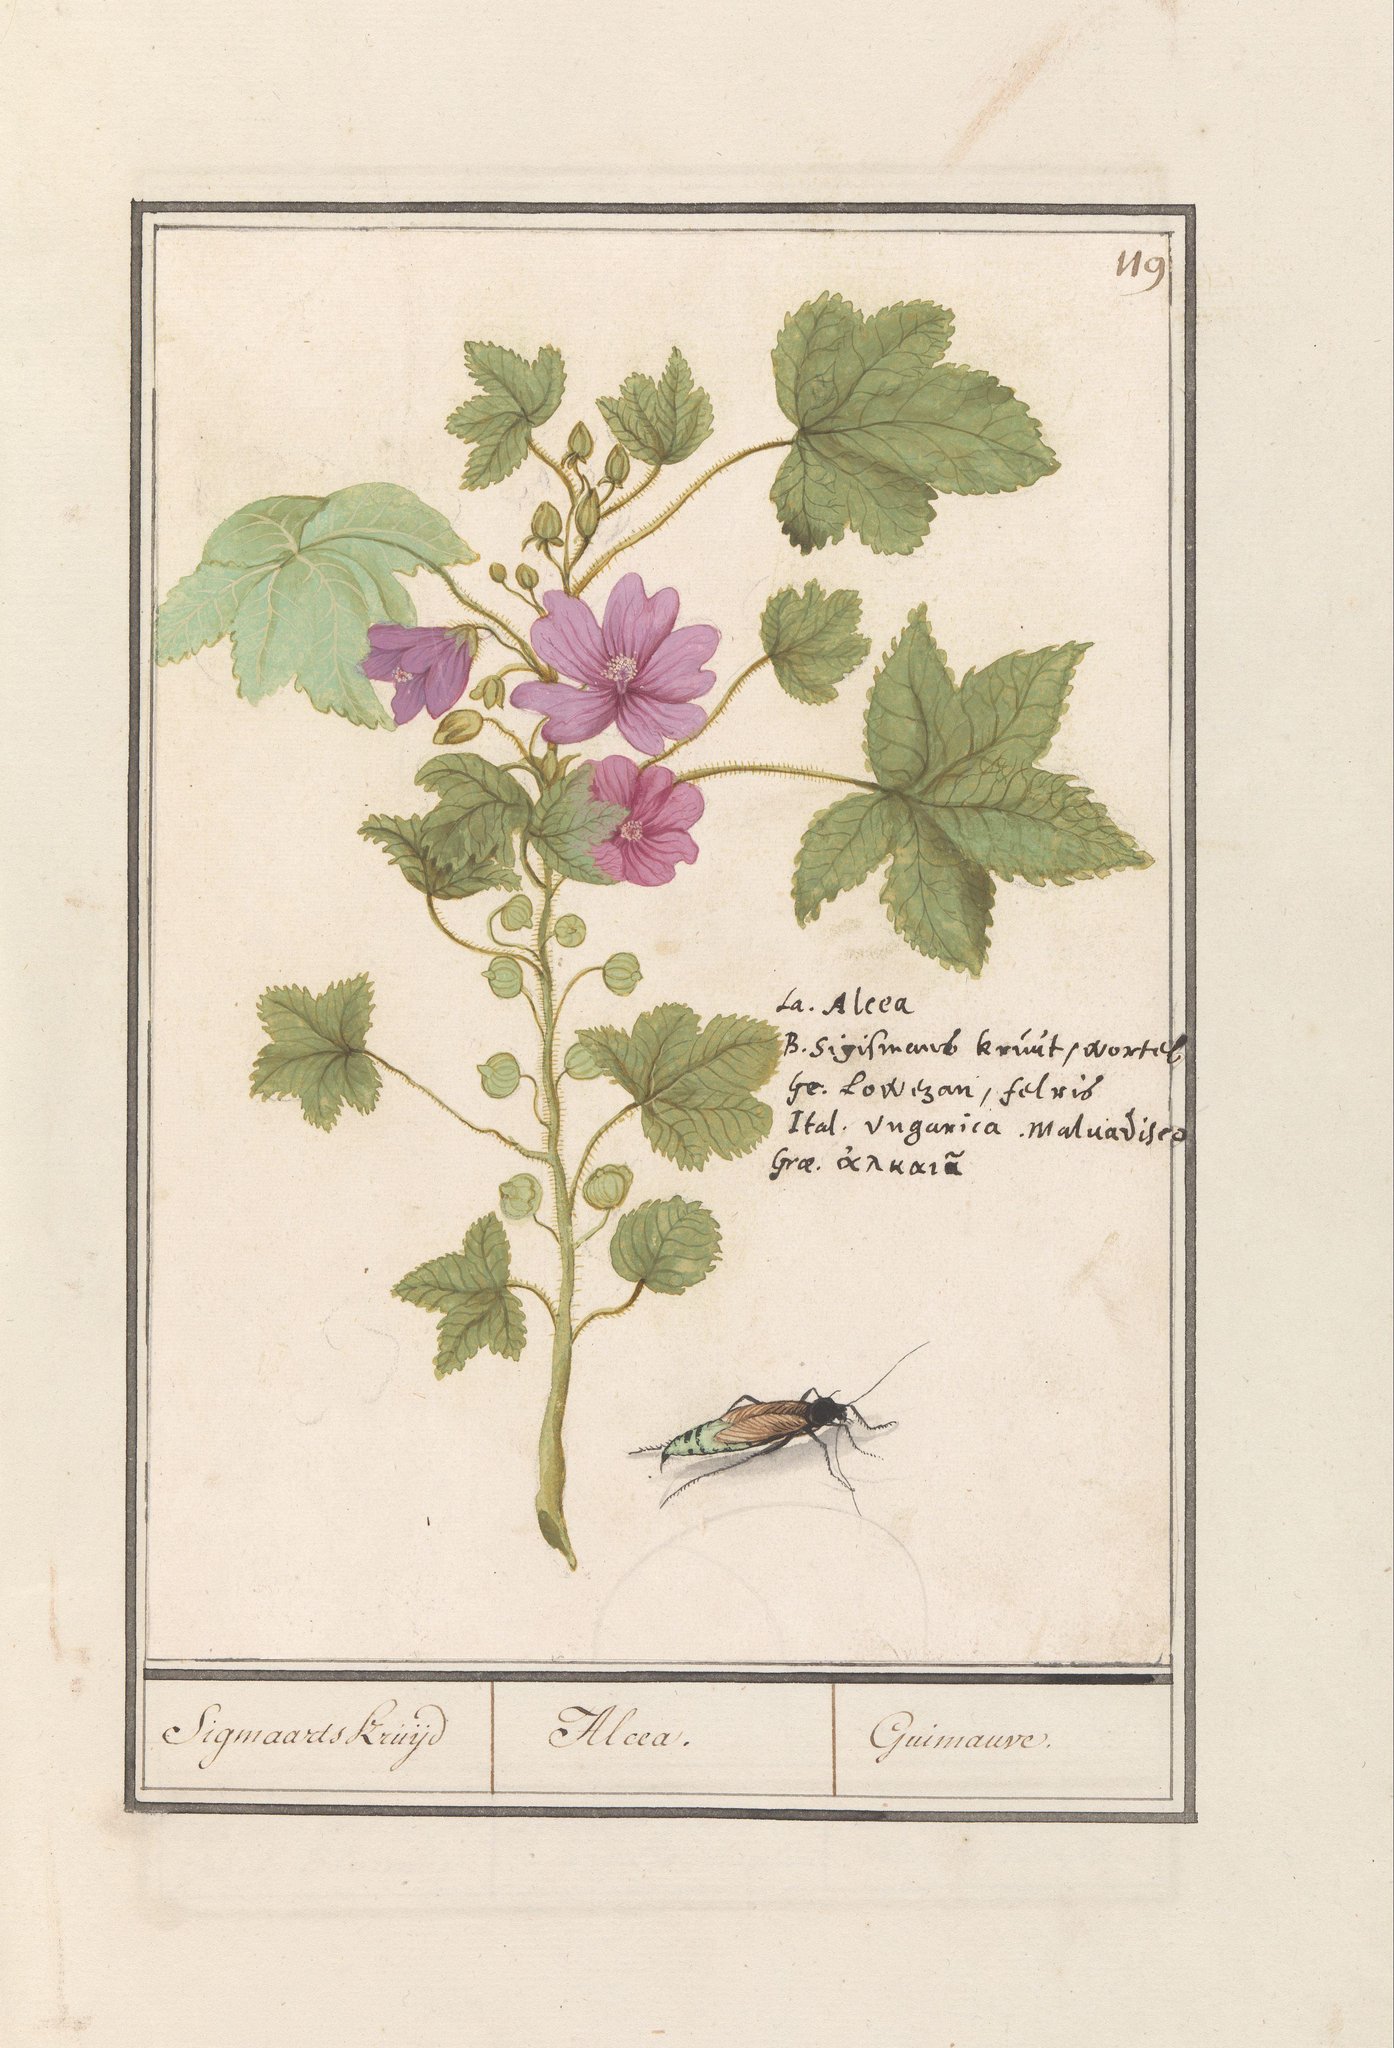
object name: drawing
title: Groot kaasjeskruid (Malva sylvestris)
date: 1596-1610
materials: paint, ink, paper, pencil, watercolor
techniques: brush, pen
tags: flowers: mallow, insects: beetle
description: Kaasjeskruid, met een kever. Rechtsboven genummerd: 119. Met de naam in vijf talen. Onderdeel van het tweede album met tekeningen van bloemen en planten. Negende van twaalf albums met tekeningen van dieren, vogels en planten bekend rond 1600, gemaakt in opdracht van keizer Rudolf II. Met toelichting in Nederlands, Latijn en Frans.